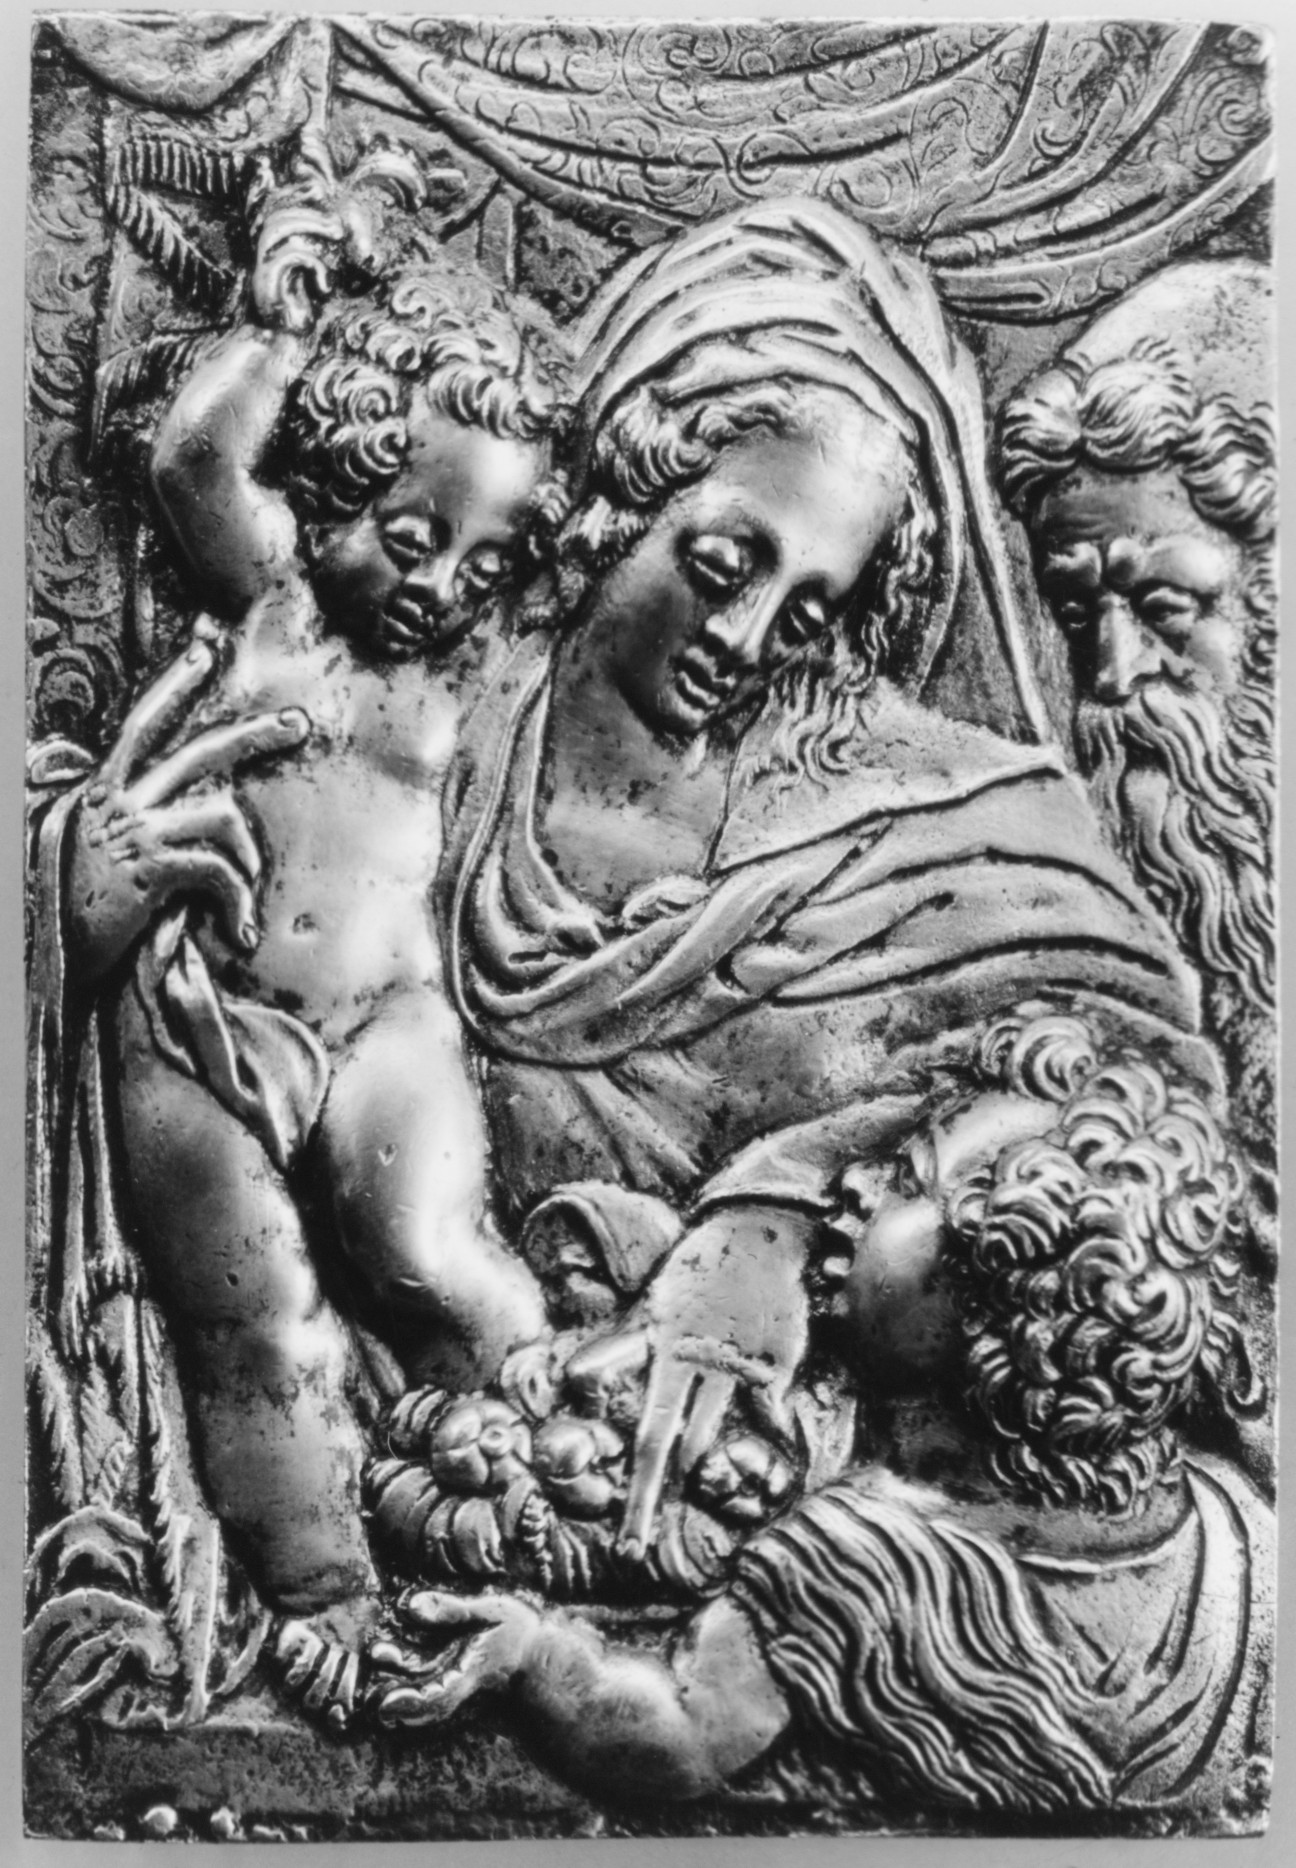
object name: plaquette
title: The Holy Family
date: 1567-1600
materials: bronze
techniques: silvered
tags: holy family,madonna and child,saints